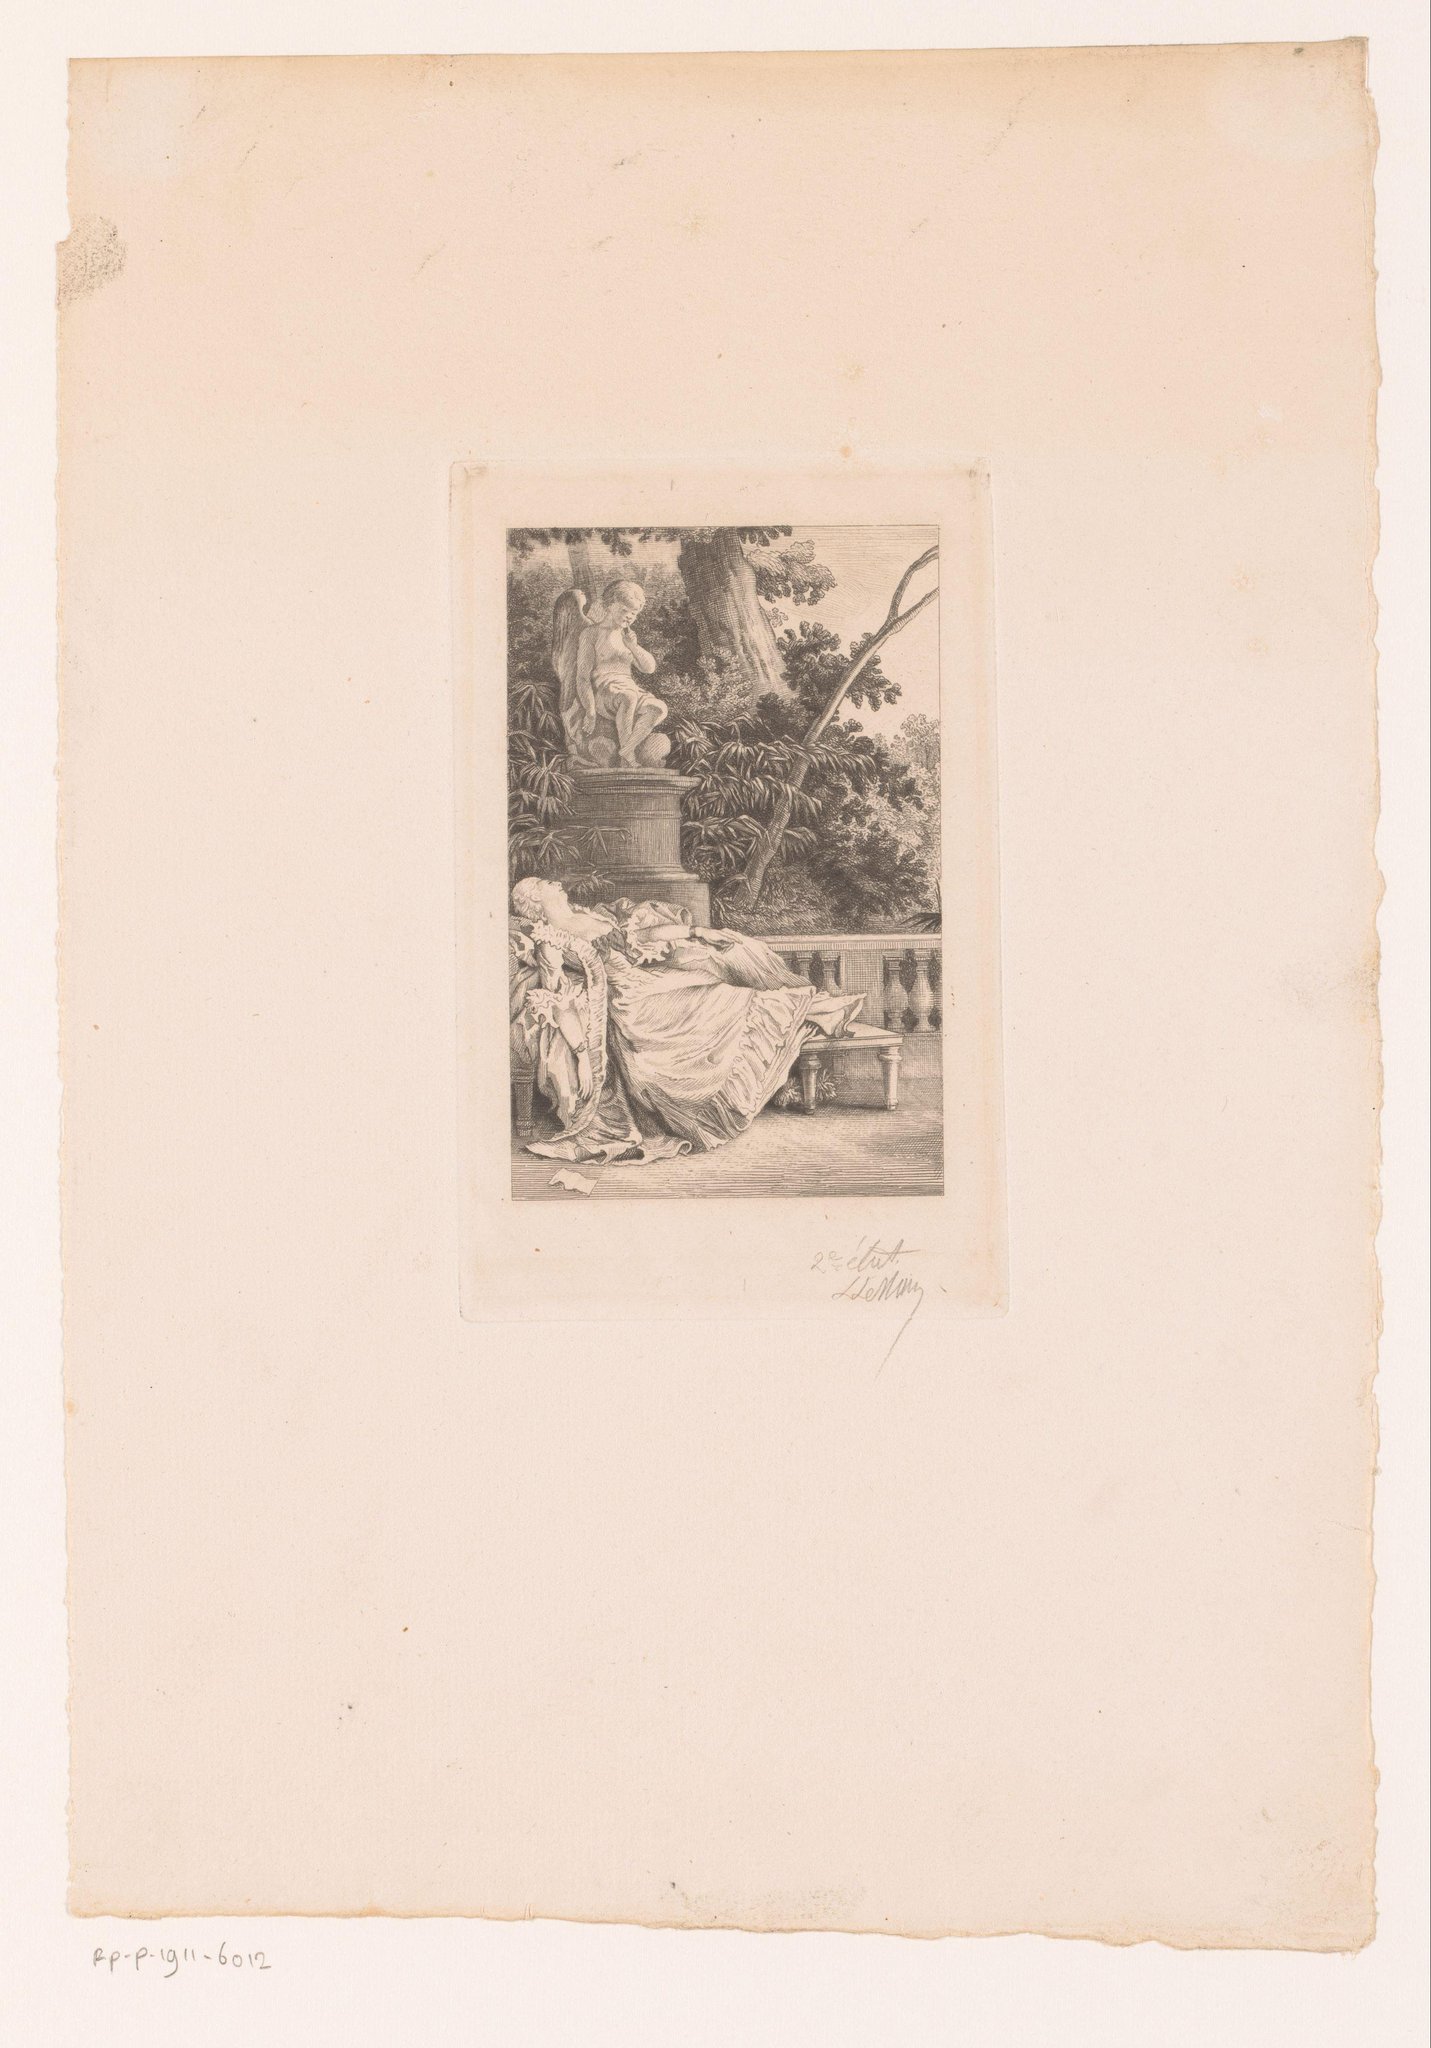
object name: print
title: Vrouw liggend op een bank in een tuin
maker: louis le nain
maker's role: print maker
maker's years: 1851-1939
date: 1861-1911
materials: paper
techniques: etching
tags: garden, lying figure - aa - female human figure, statues, sculptures in garden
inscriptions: inscription: ‘2e état LLeNain’, collector's mark: Lugt 2228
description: Links staat een tuinbeeld van Cupido met zijn vinger voor zijn mond. Dit beeld en het briefje op de grond naast de vrouw, verwijzen naar een mogelijke (geheime) liefde van de vrouw.